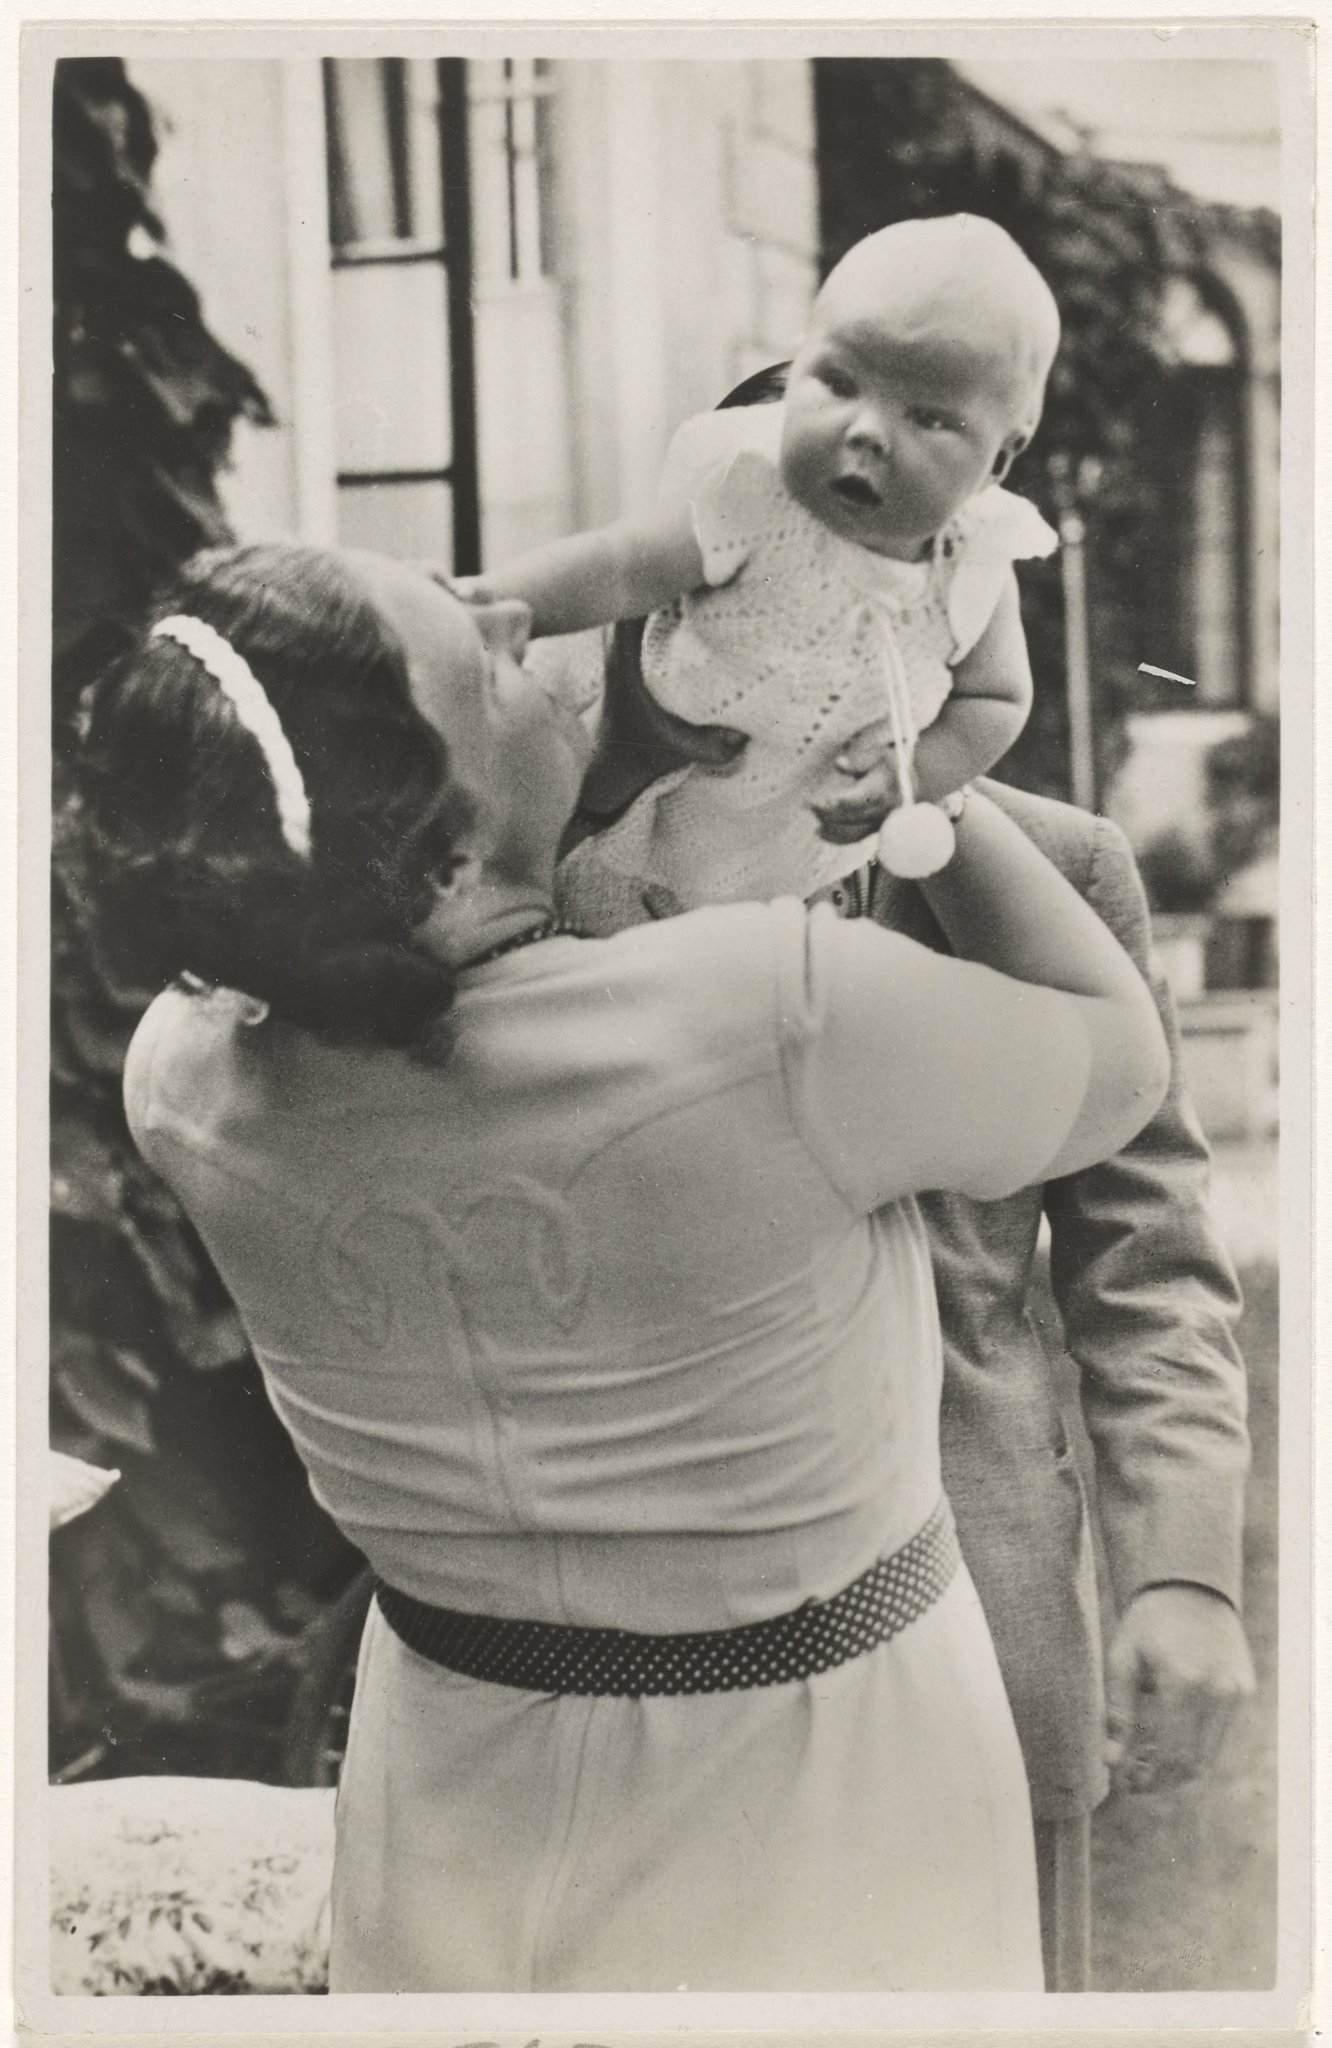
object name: ansichtkaart, prentbriefkaart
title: Portret van Juliana, koningin der Nederlanden, en Beatrix, koningin der Nederlanden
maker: Anonymous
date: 1938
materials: photographic support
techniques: photography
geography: netherlands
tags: beatrix (koningin der nederlanden), the hague, juliana of the netherlands, germany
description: De hier vermelde titel verwijst naar de hoogst verkregen titel van de geportretteerde, niet per se naar de titel die de geportretteerde op deze voorstelling draagt.